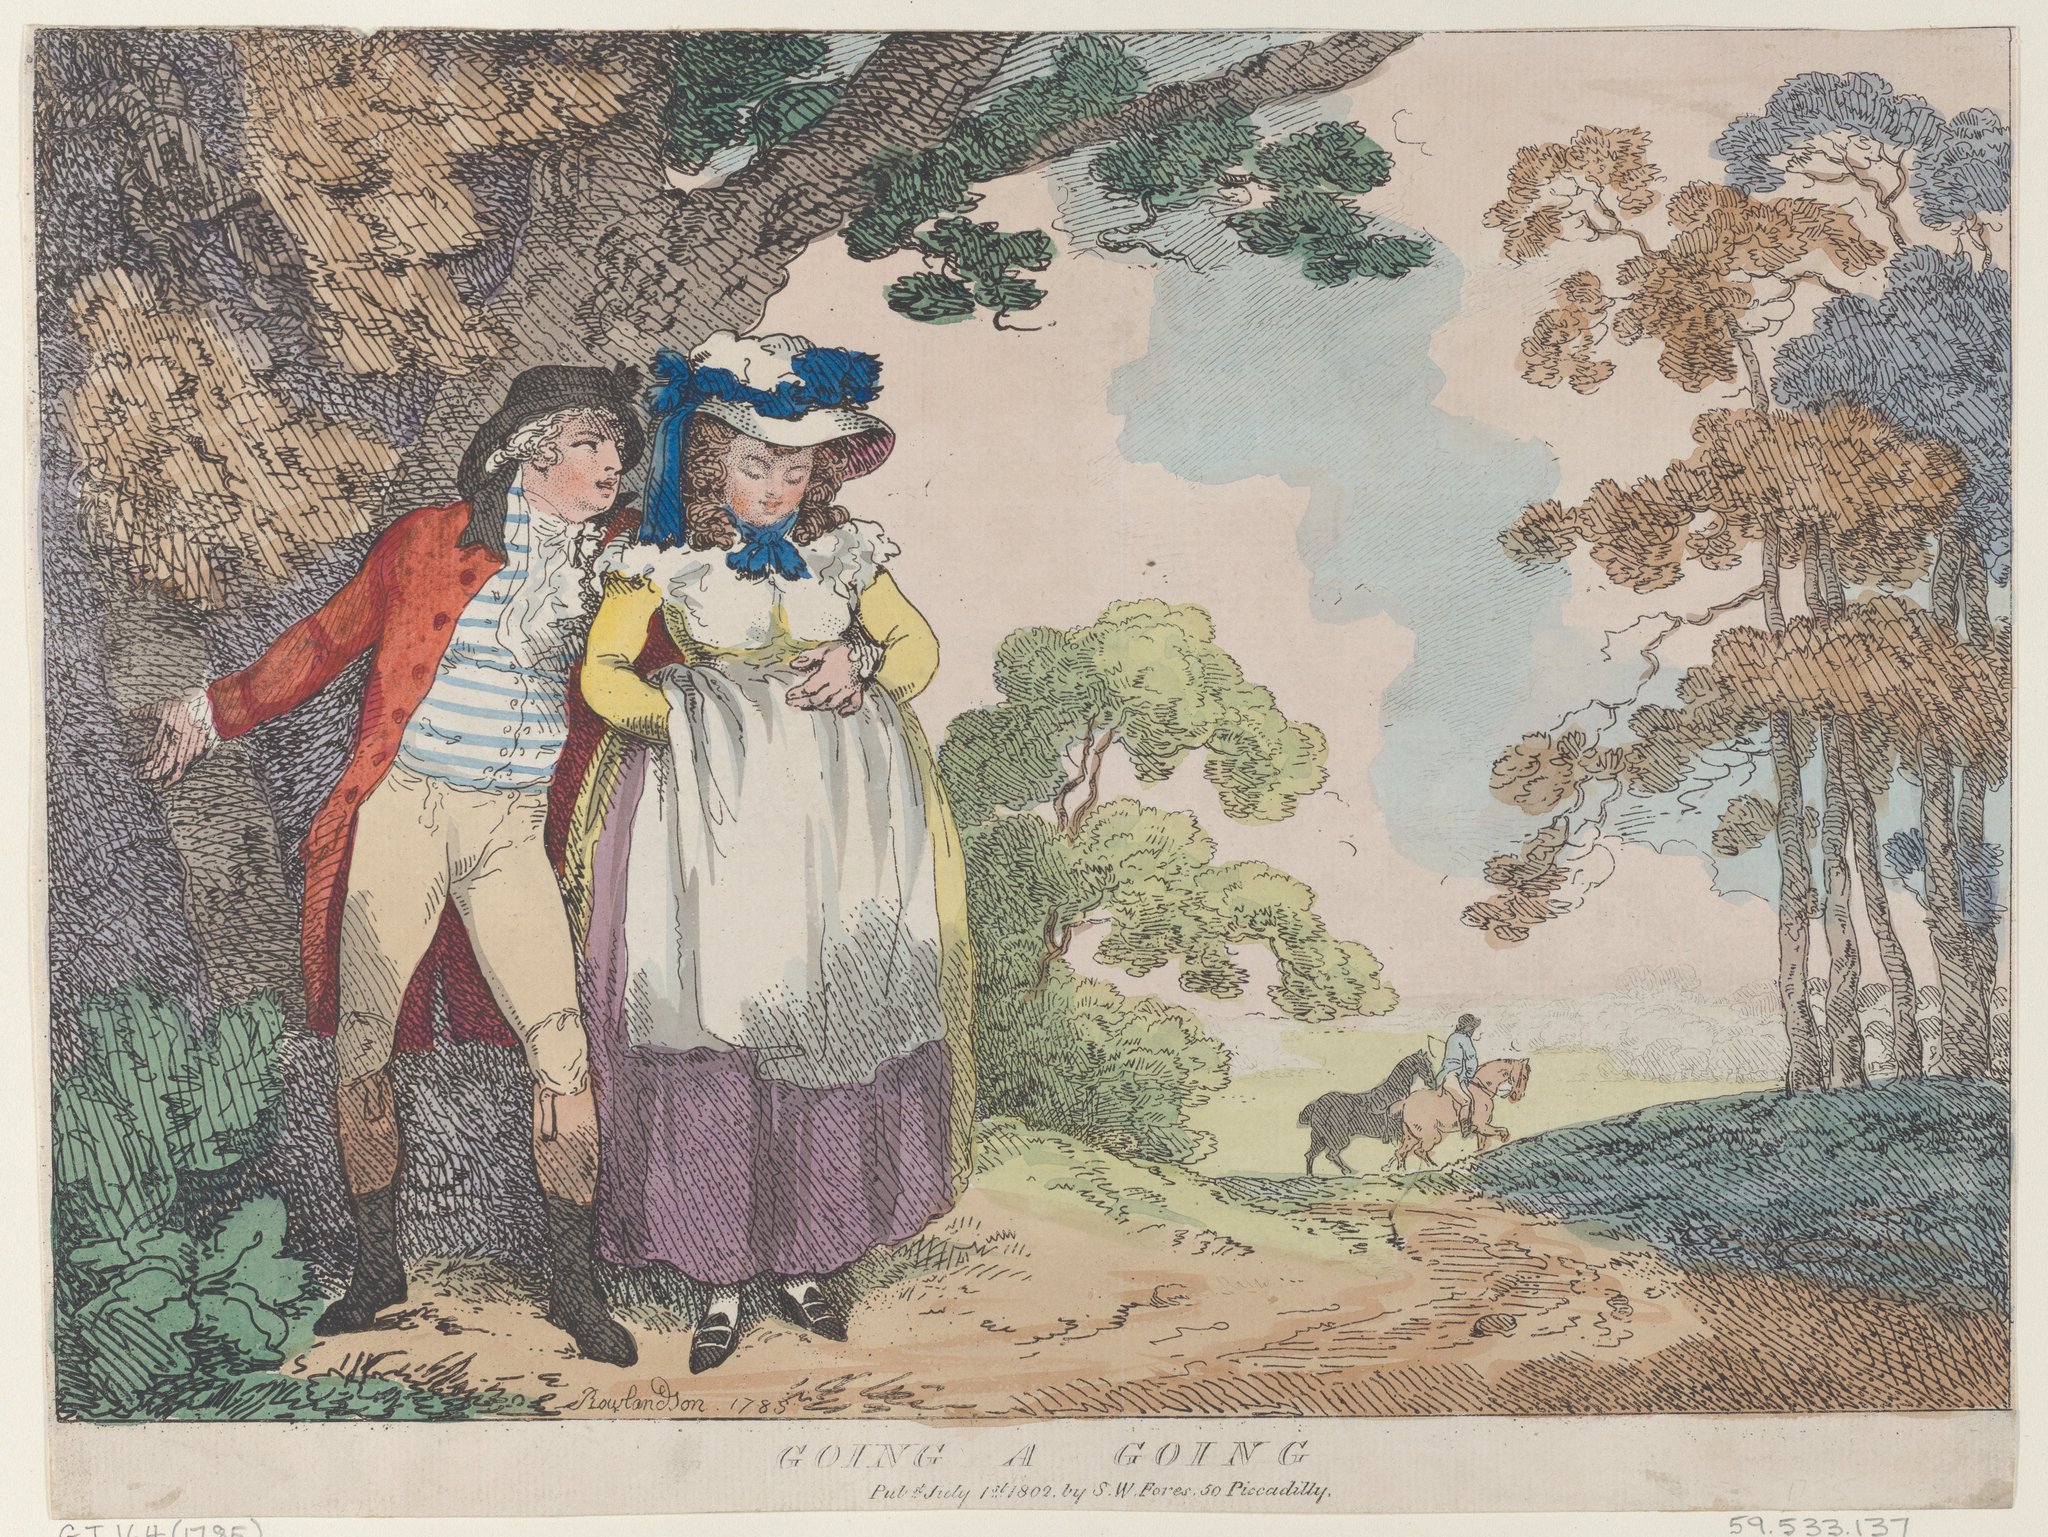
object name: print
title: Going, A-Going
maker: thomas rowlandson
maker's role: artist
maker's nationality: british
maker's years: 1757-1827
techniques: etching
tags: couples,men,women